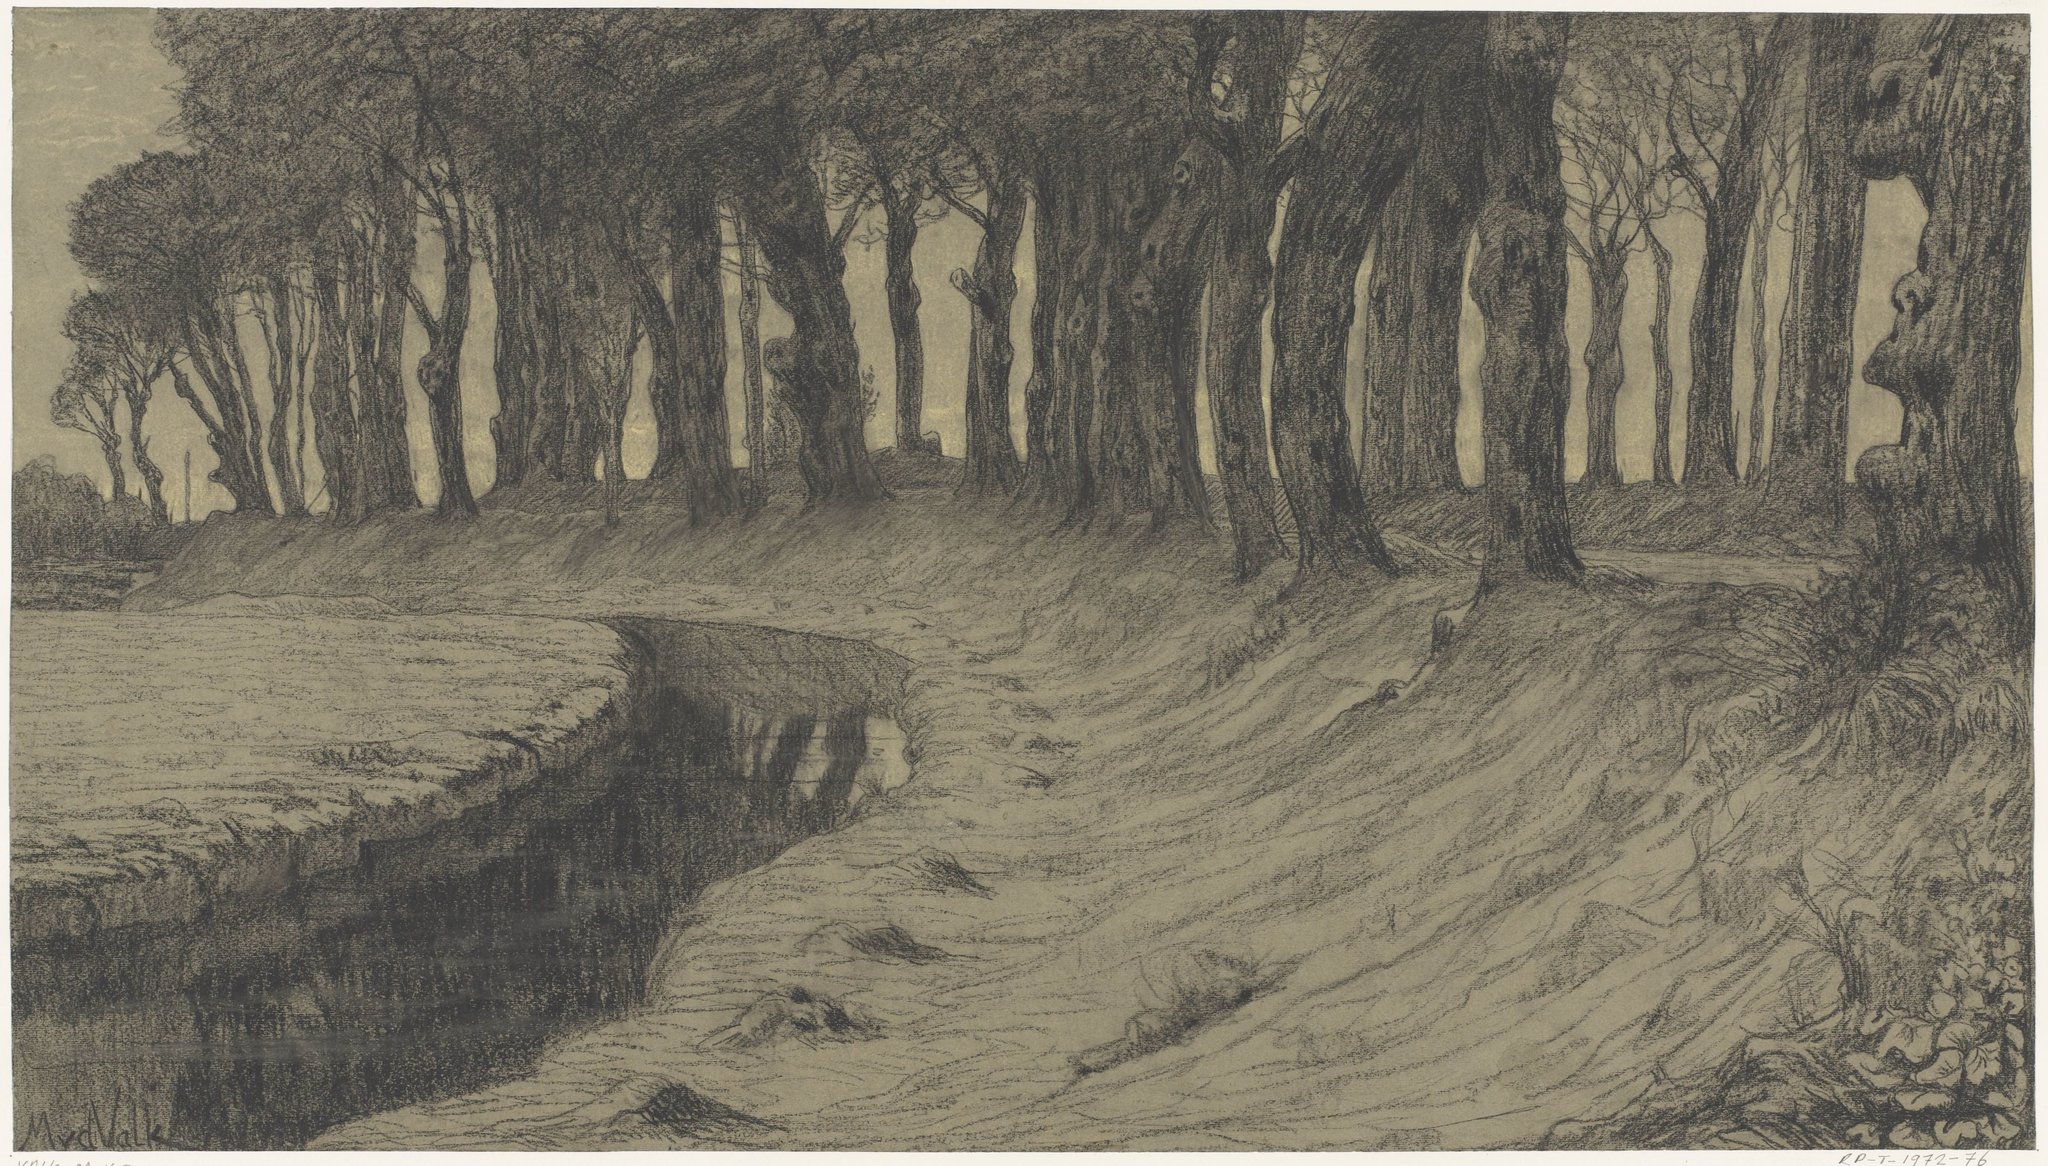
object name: drawing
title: Bomen langs een weg over een dijk of wal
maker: maurits van der valk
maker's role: draughtsman, print maker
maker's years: 1857-1935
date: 1867-1935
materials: chalk, paper